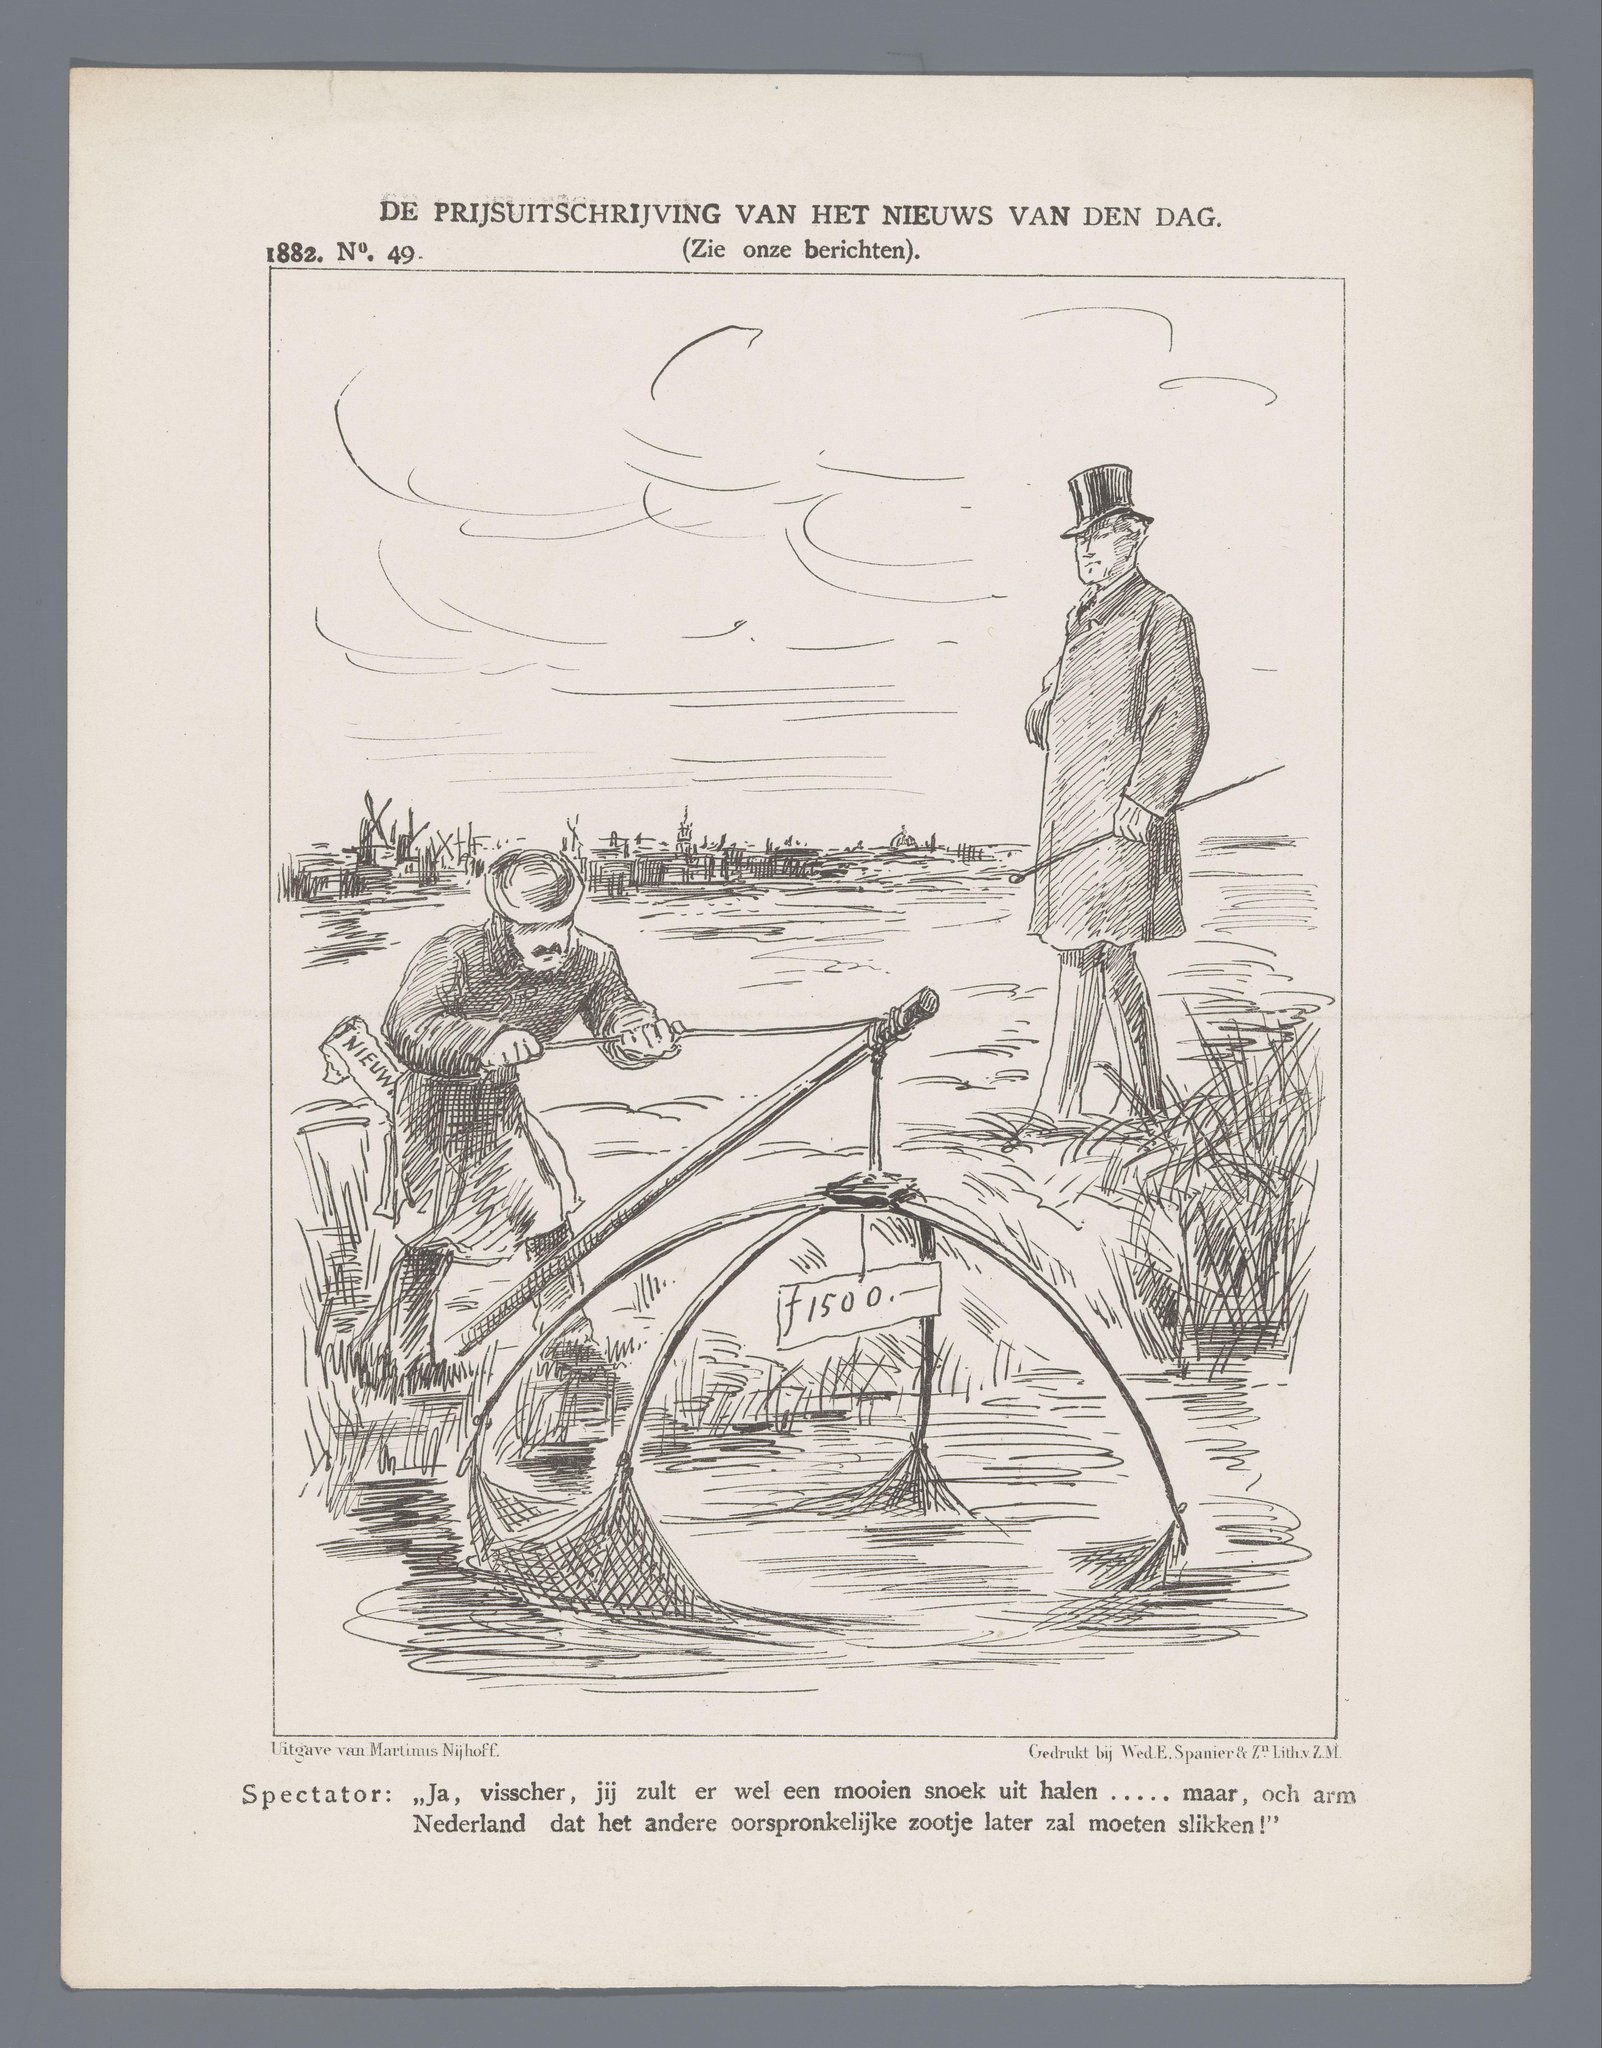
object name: cartoon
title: De prijsuitschrijving van het Nieuws van den Dag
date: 1882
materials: paper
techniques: lithograph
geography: netherlands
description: Spotprent op de prijsvraag uitgeschreven door het Nieuws van de Dag. Plaat verschenen bij het weekblad De Nederlandsche Spectator, nr. 49, 1882.